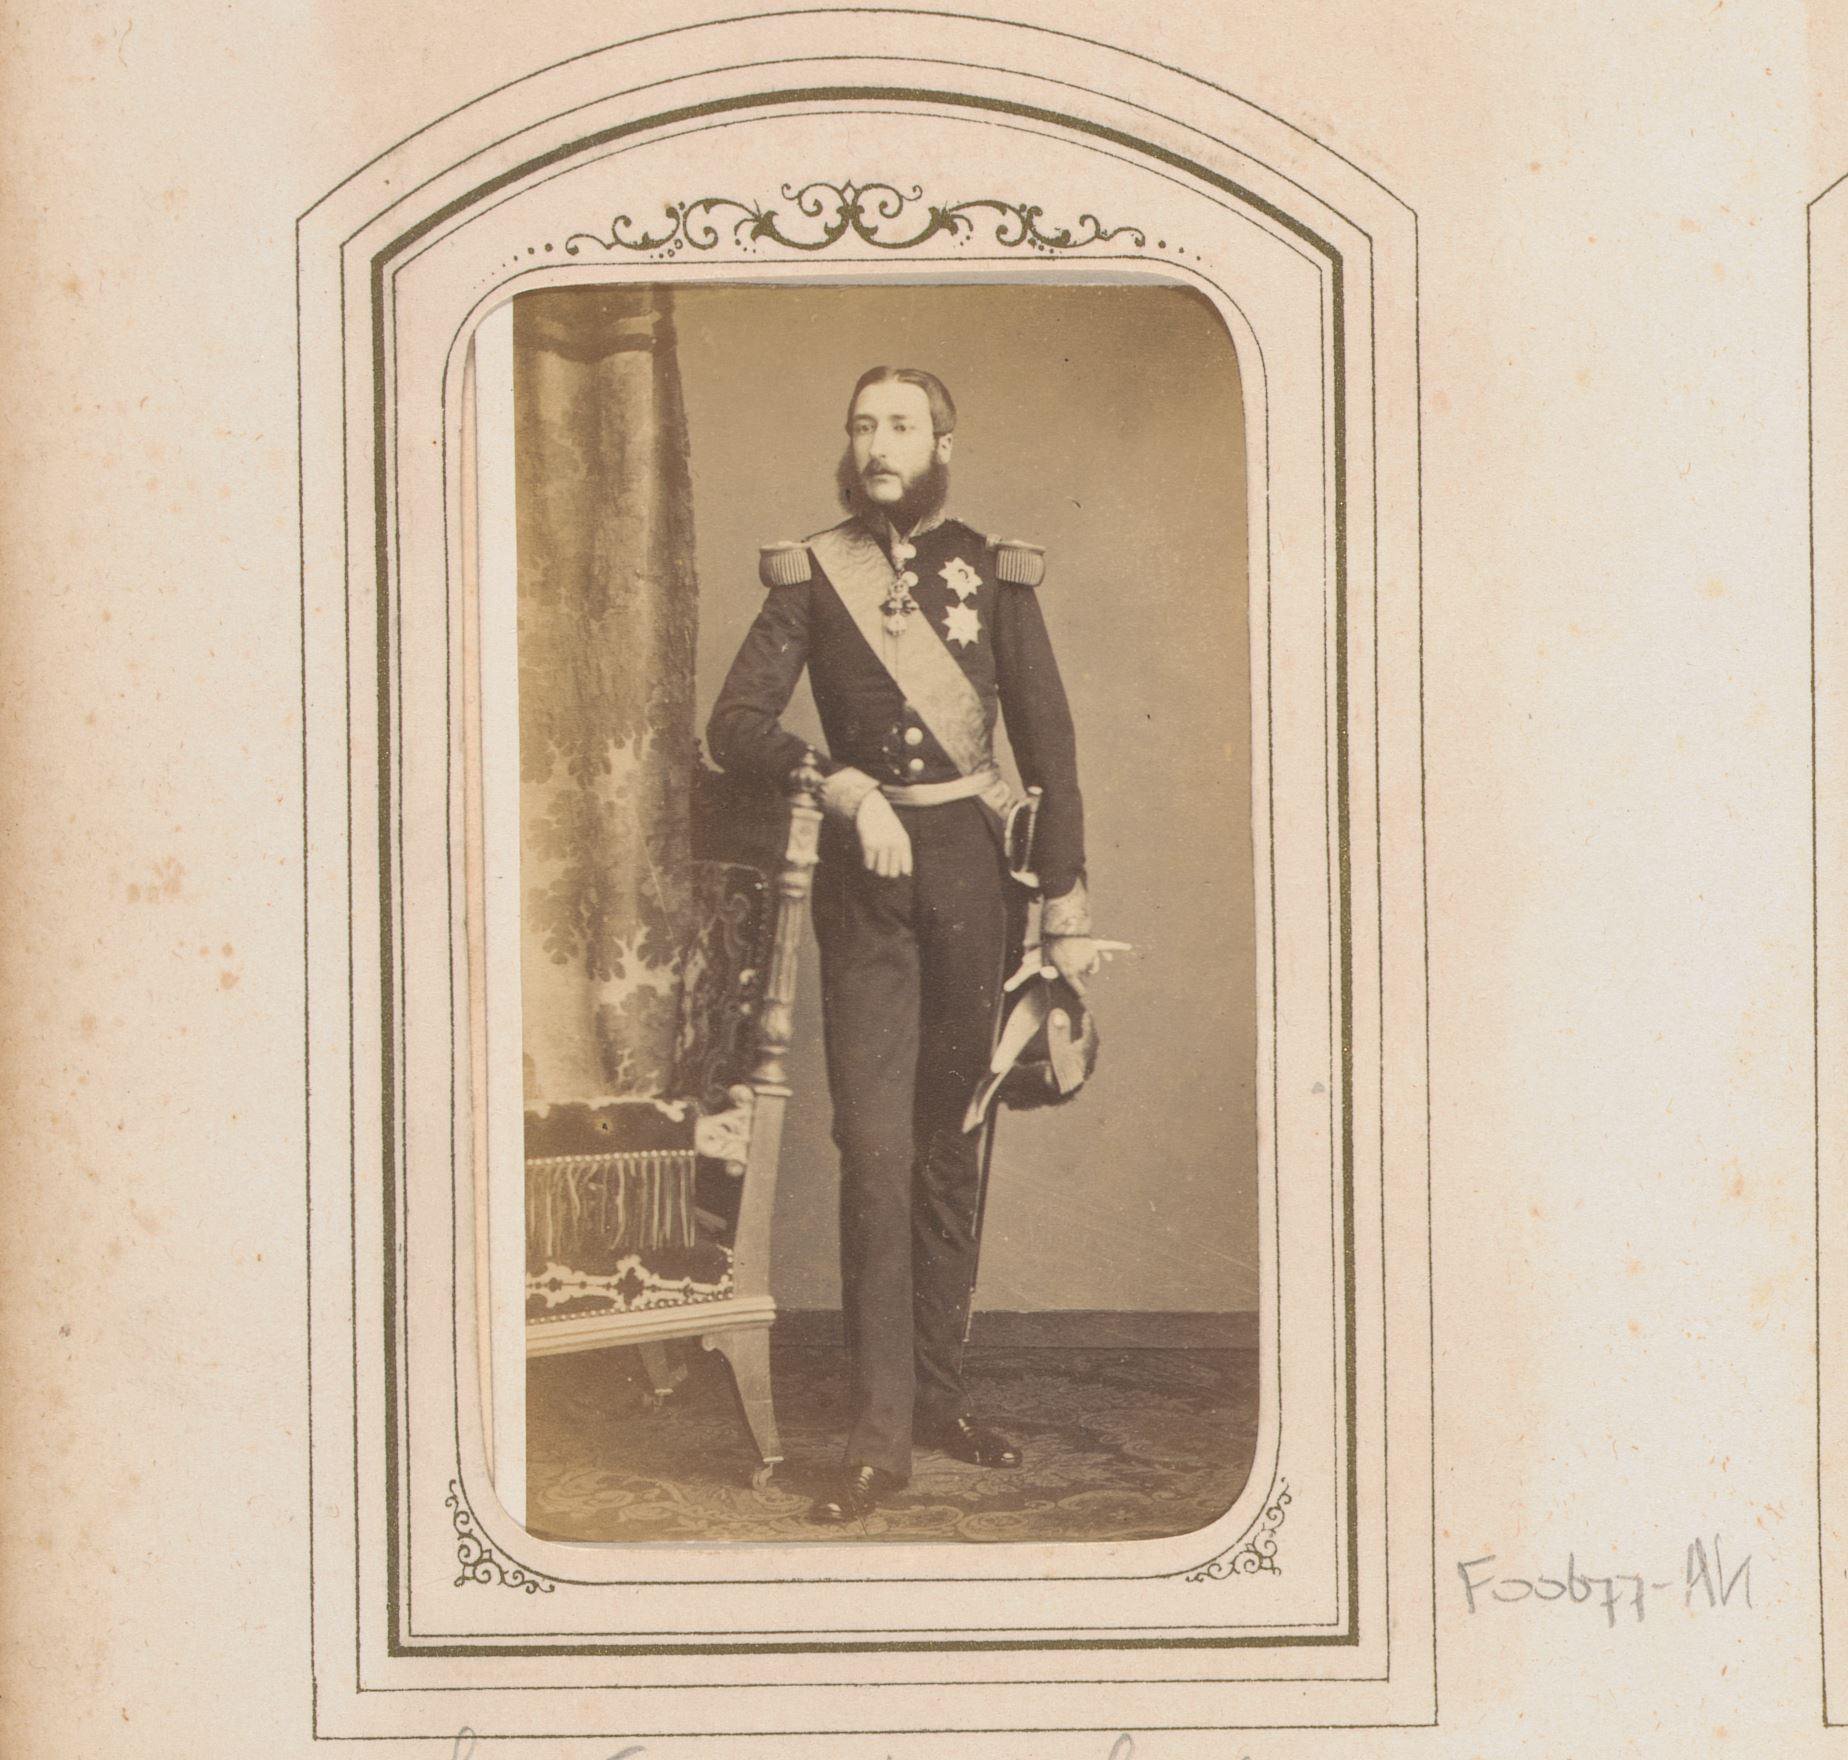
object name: photograph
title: Portret van Leopold II, koning van België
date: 1855-1870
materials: cardboard, photographic support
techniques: albumen print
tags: brussels, laeken, leopold ii (koning der belgen), historical persons, king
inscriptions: annotation: ‘hertog v Brabant, later/ Leopold II, koning van België/ 1835-1909’, inscription: ‘ATELIER DE PHOTOGRAPHIE/ GHÉMAR FRÈRES,/ PHOTOGRAPHES DU ROI,/ 27, rue de l'Ecuyer./ entrée par la porte cochère, BRUXELLES.’